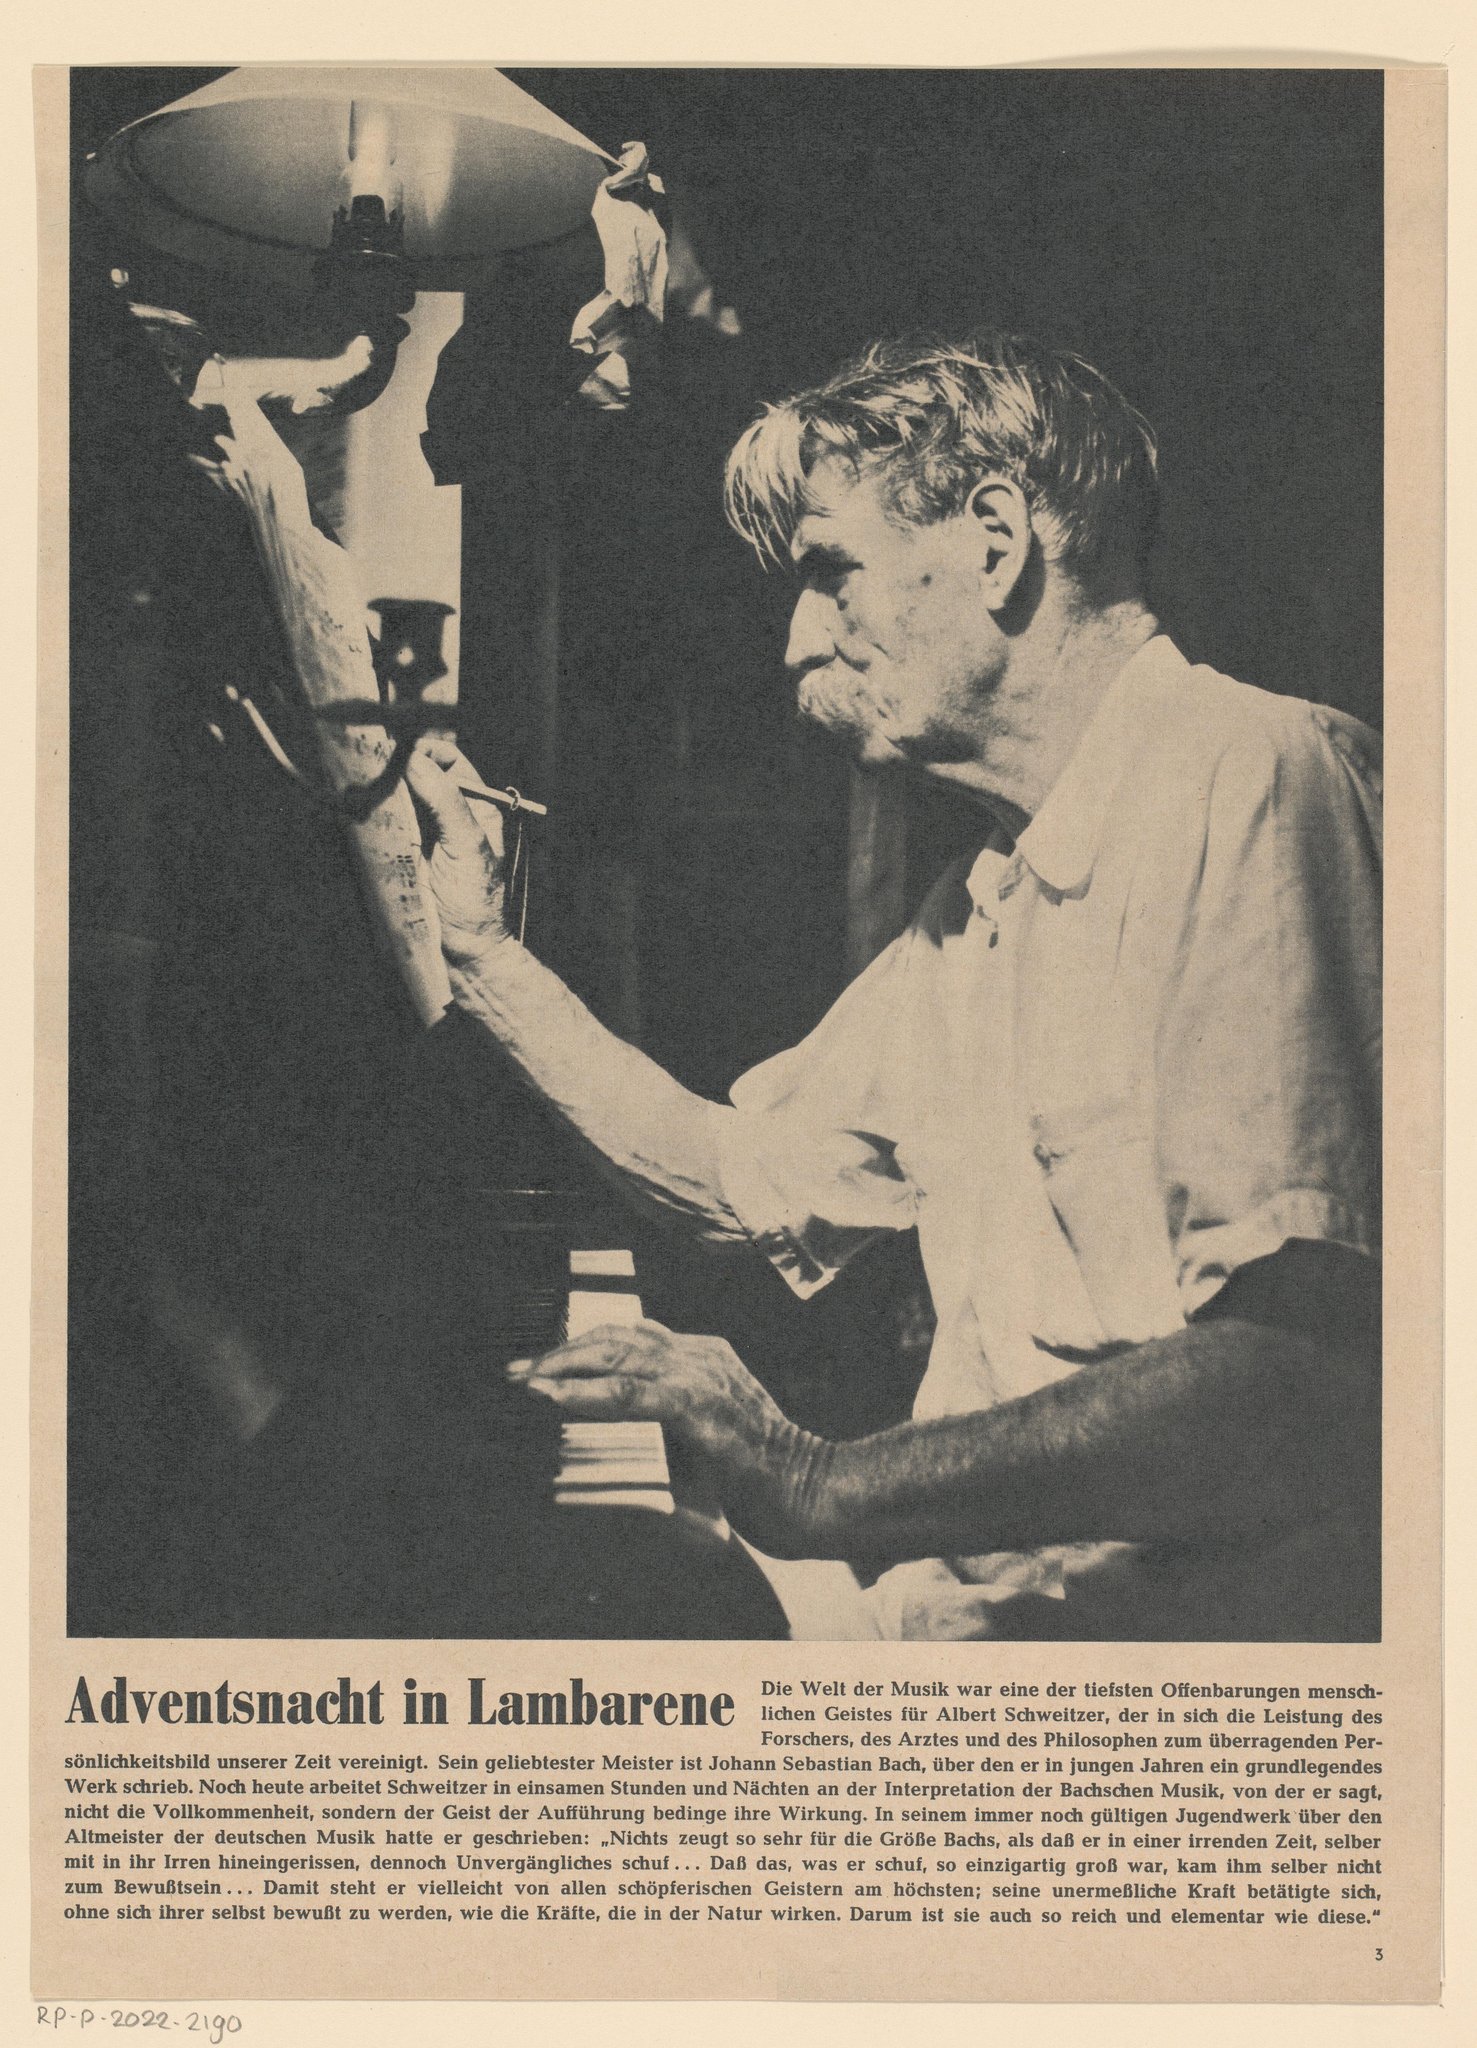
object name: photomechanical print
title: Portret van Albert Schweitzer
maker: Anonymous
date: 1939-1948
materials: paper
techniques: letterpress printing, rotogravure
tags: theologian, scholar, philosopher, historical persons, portrait of a musician, physician, doctor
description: Fotomechanische afdruk uit een onbekende publicatie.